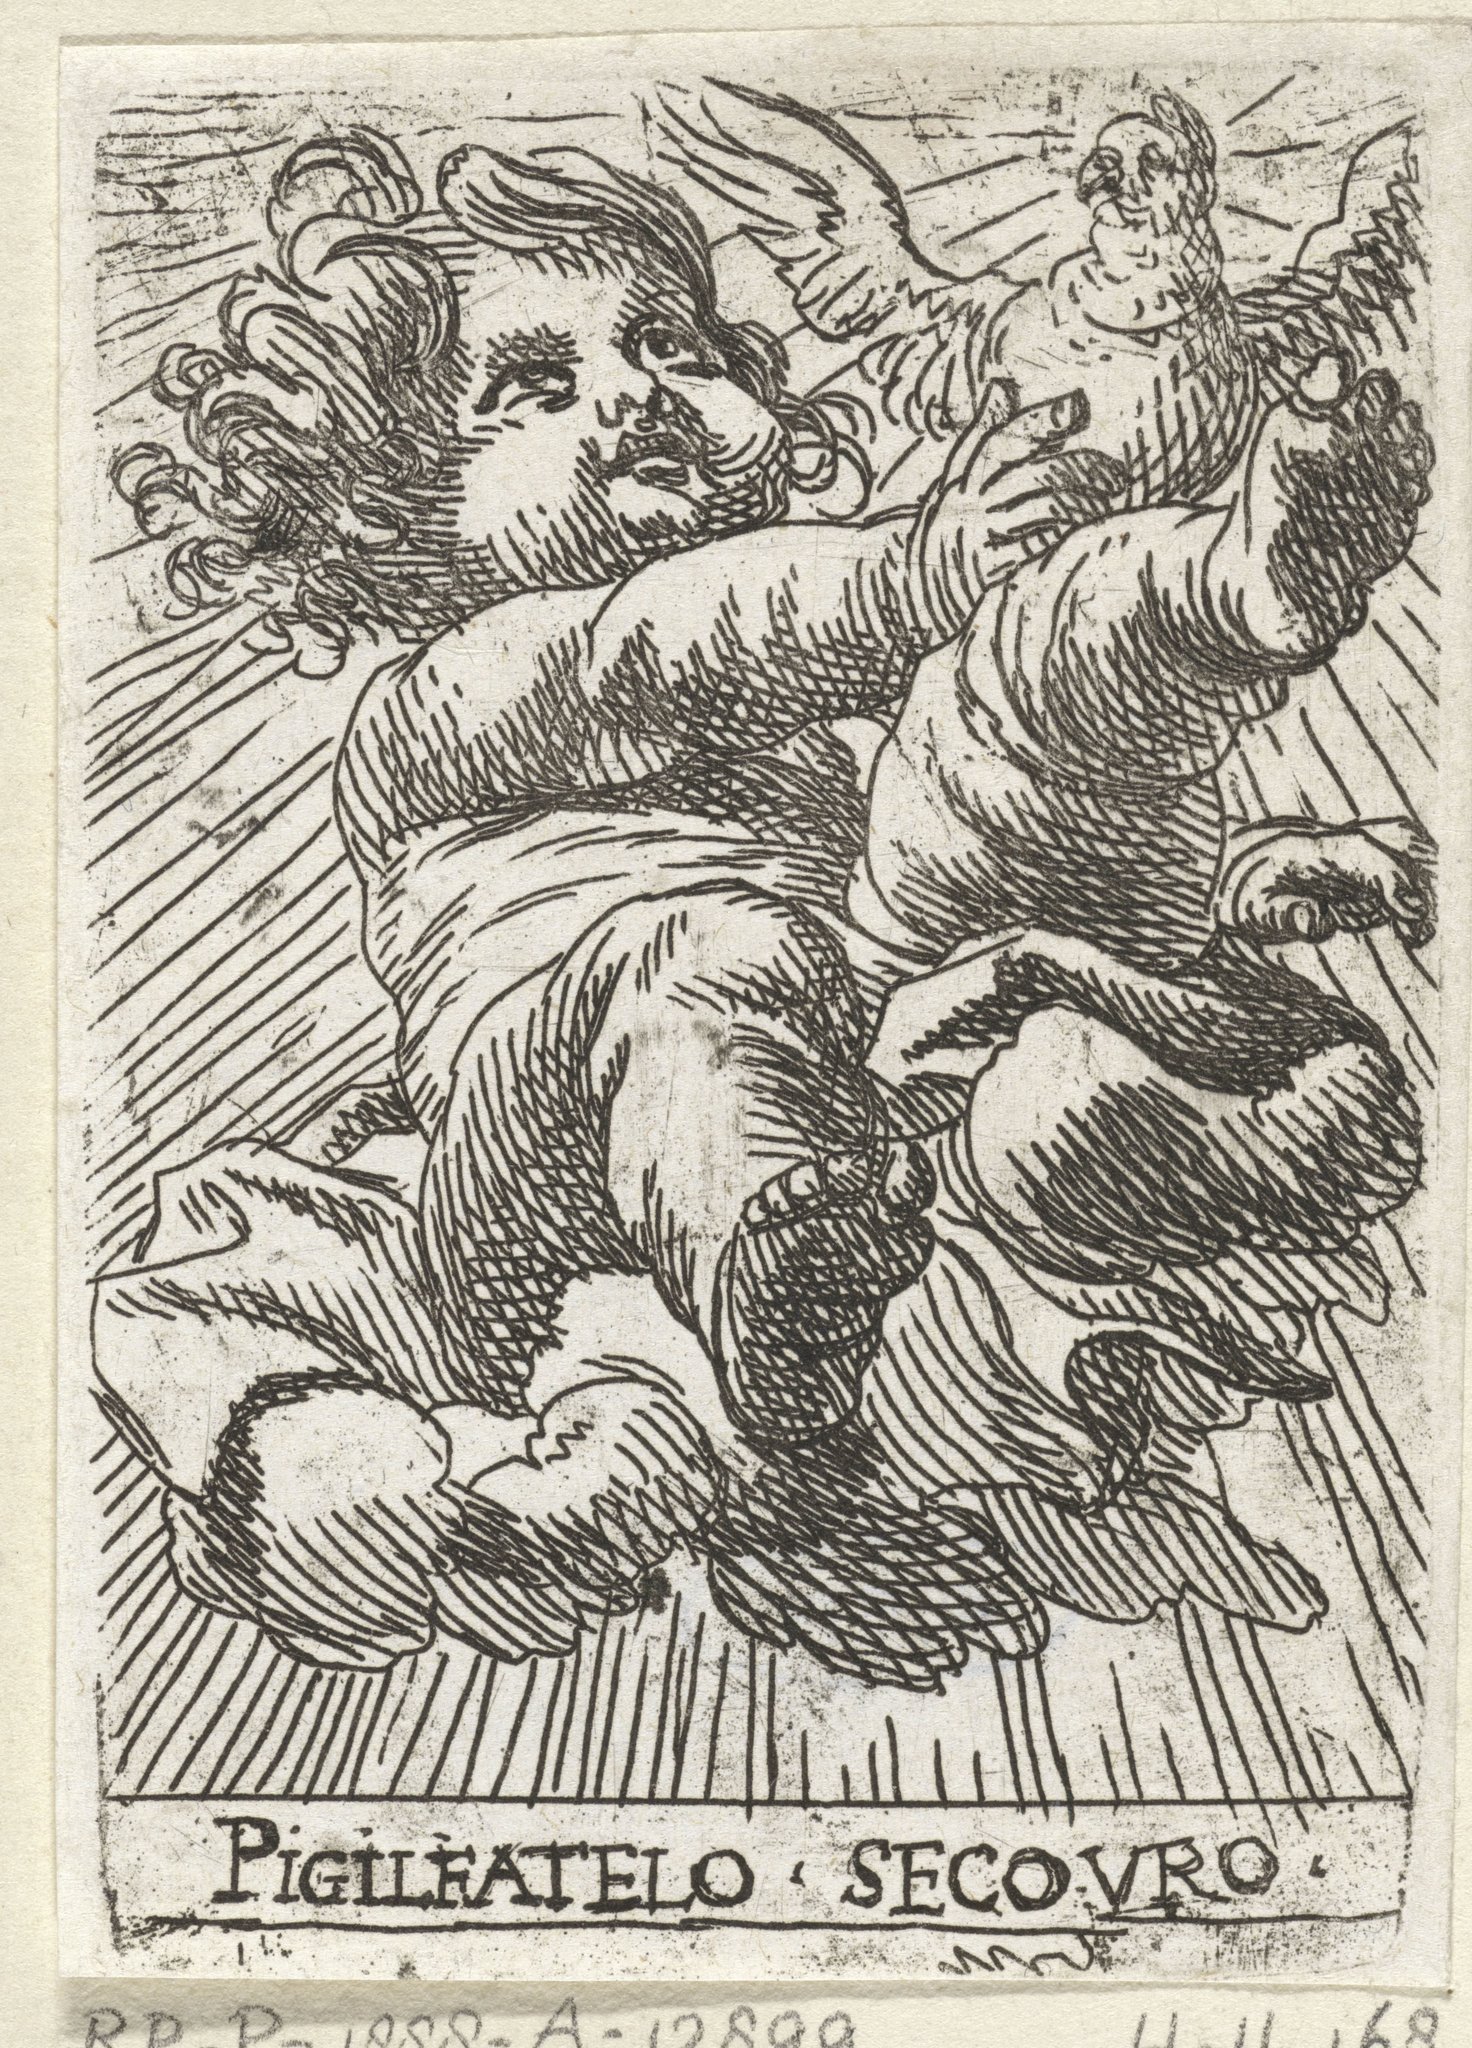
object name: print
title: Kind met duif op een wolk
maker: cornelis schut (i)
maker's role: draughtsman, print maker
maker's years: 1597-1655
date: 1618-1655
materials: paper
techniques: etching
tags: child, sitting or standing on clouds, doves, pigeons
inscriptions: collector's mark: Lugt 2228